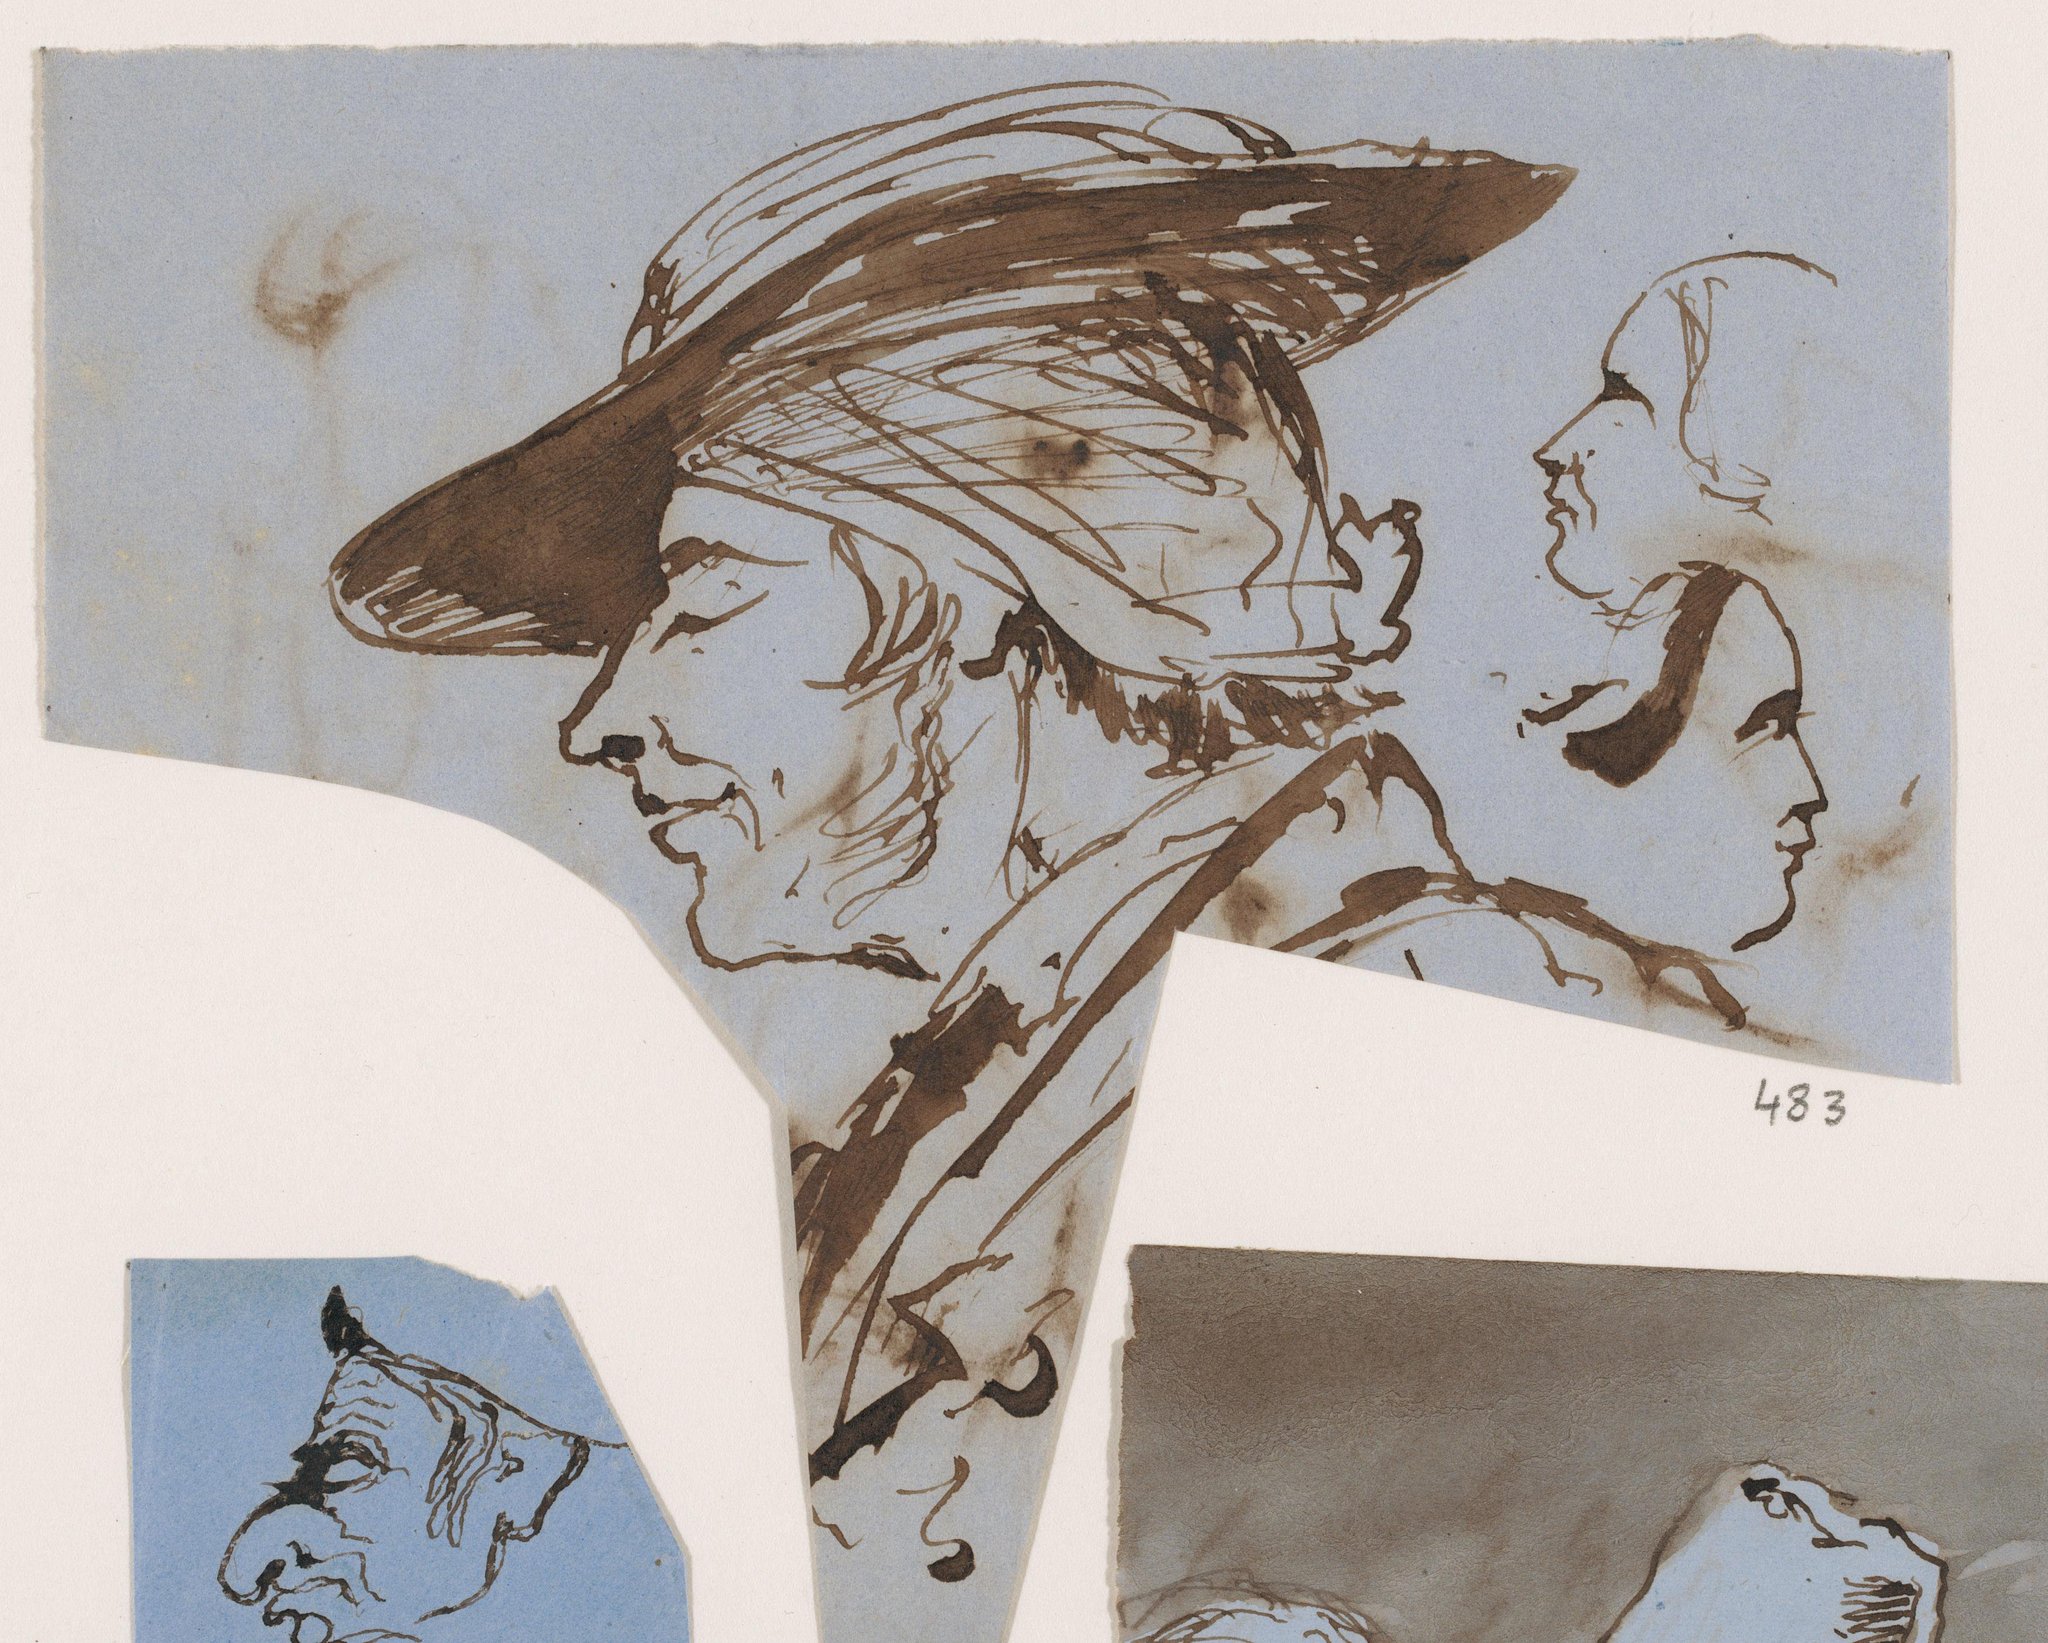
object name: drawing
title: Koppen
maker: johannes tavenraat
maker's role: draughtsman, painter, print maker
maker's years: 1809-1881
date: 1840-1880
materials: ink, paper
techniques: pen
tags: head (human)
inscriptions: collector's mark: Lugt 2228